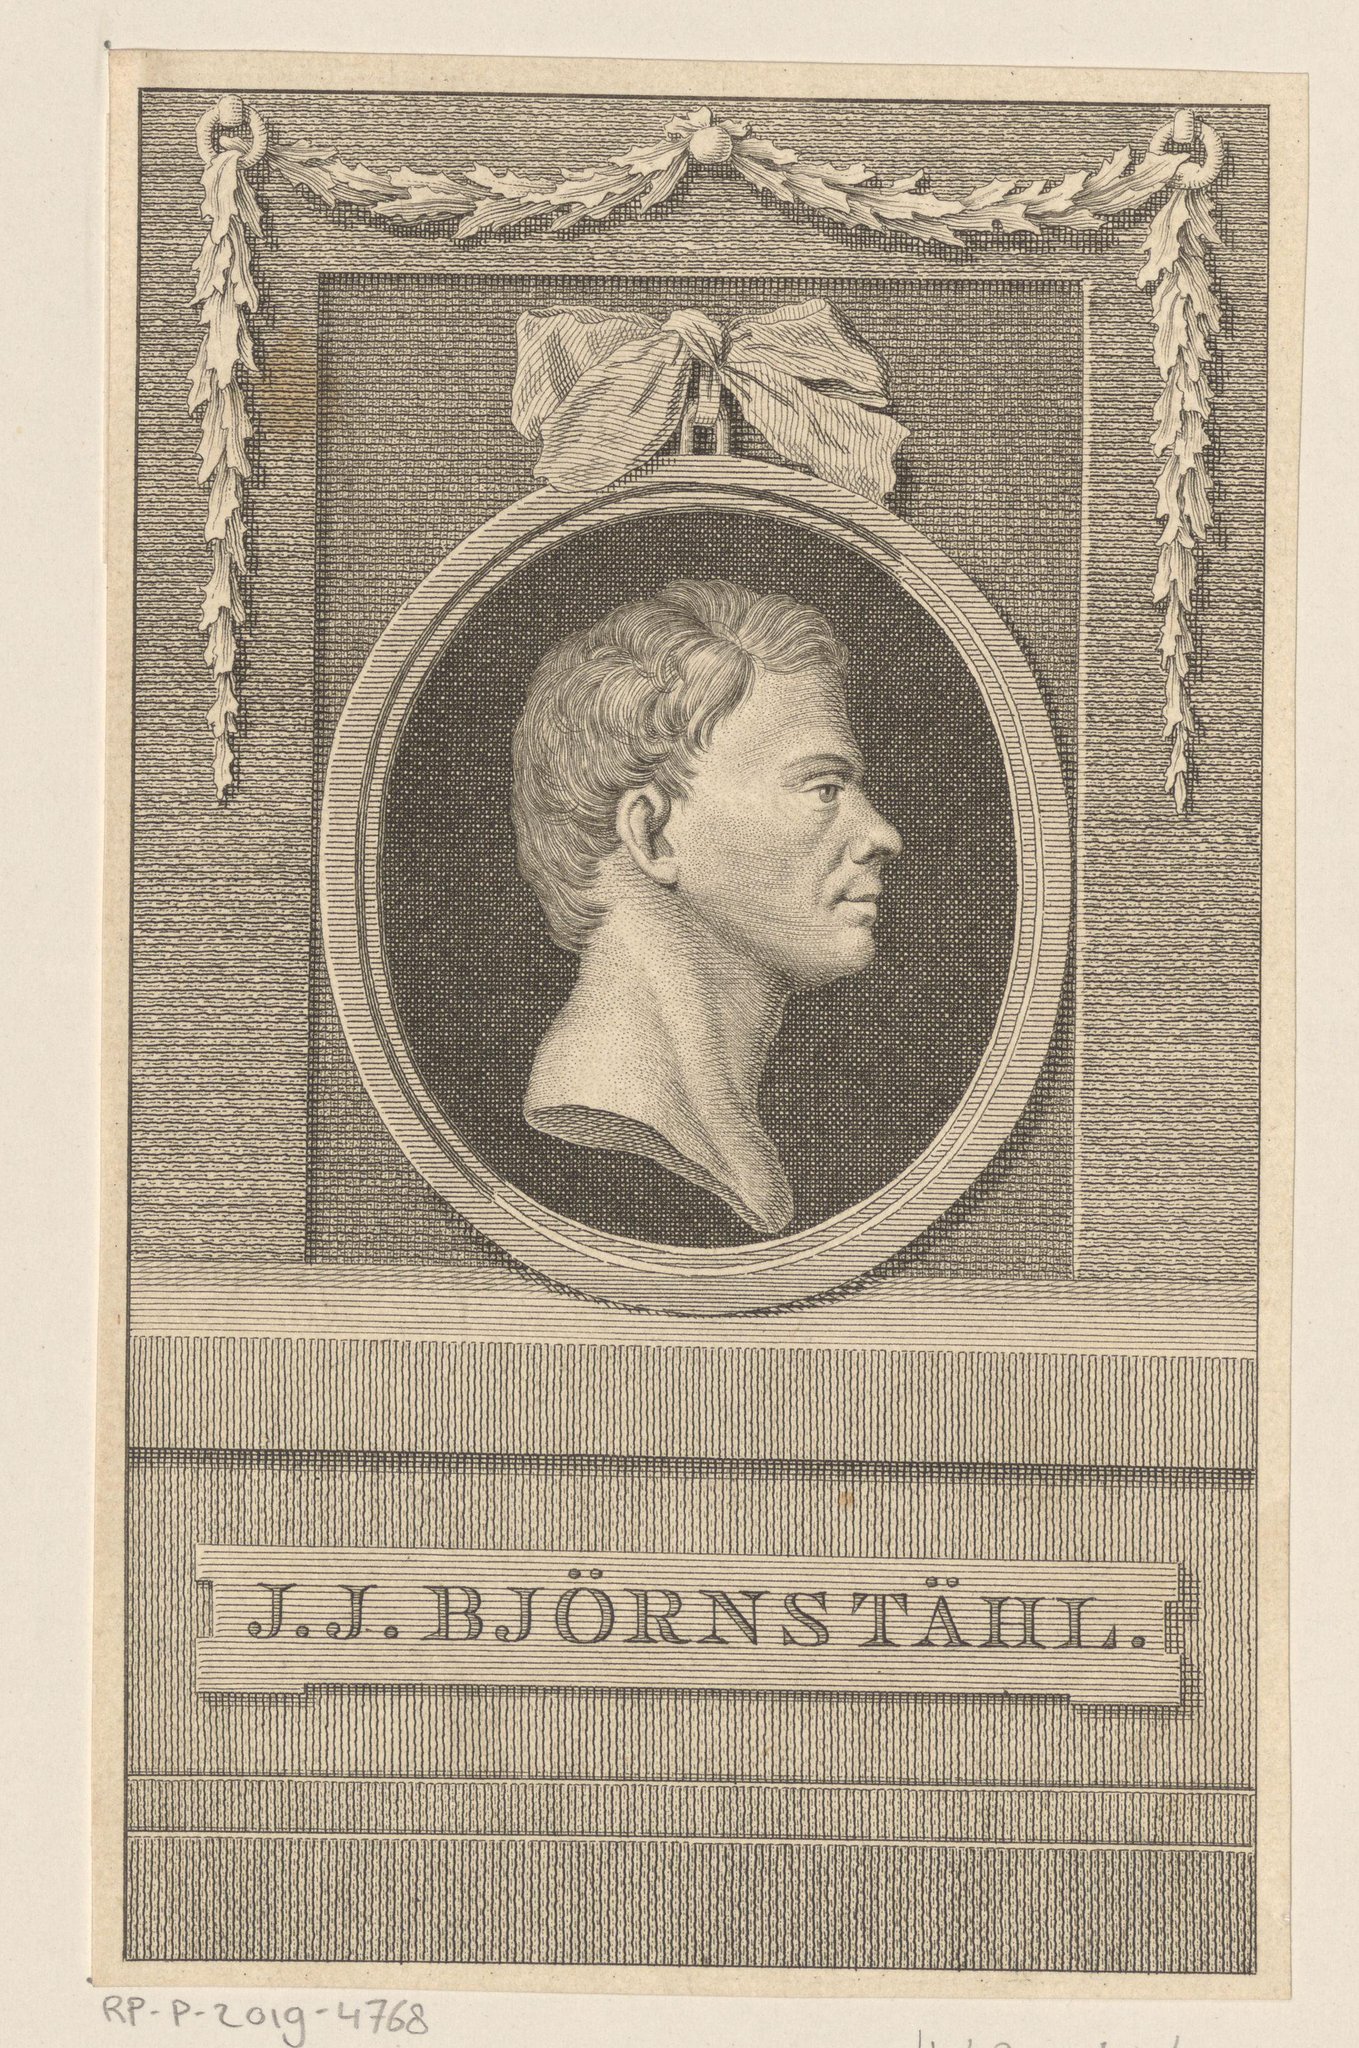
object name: print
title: Portret van Jacob Jonas Björnståhl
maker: Anonymous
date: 1765-1799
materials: paper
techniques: engraving, etching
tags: traveler, historical persons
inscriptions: collector's mark: Lugt 2228